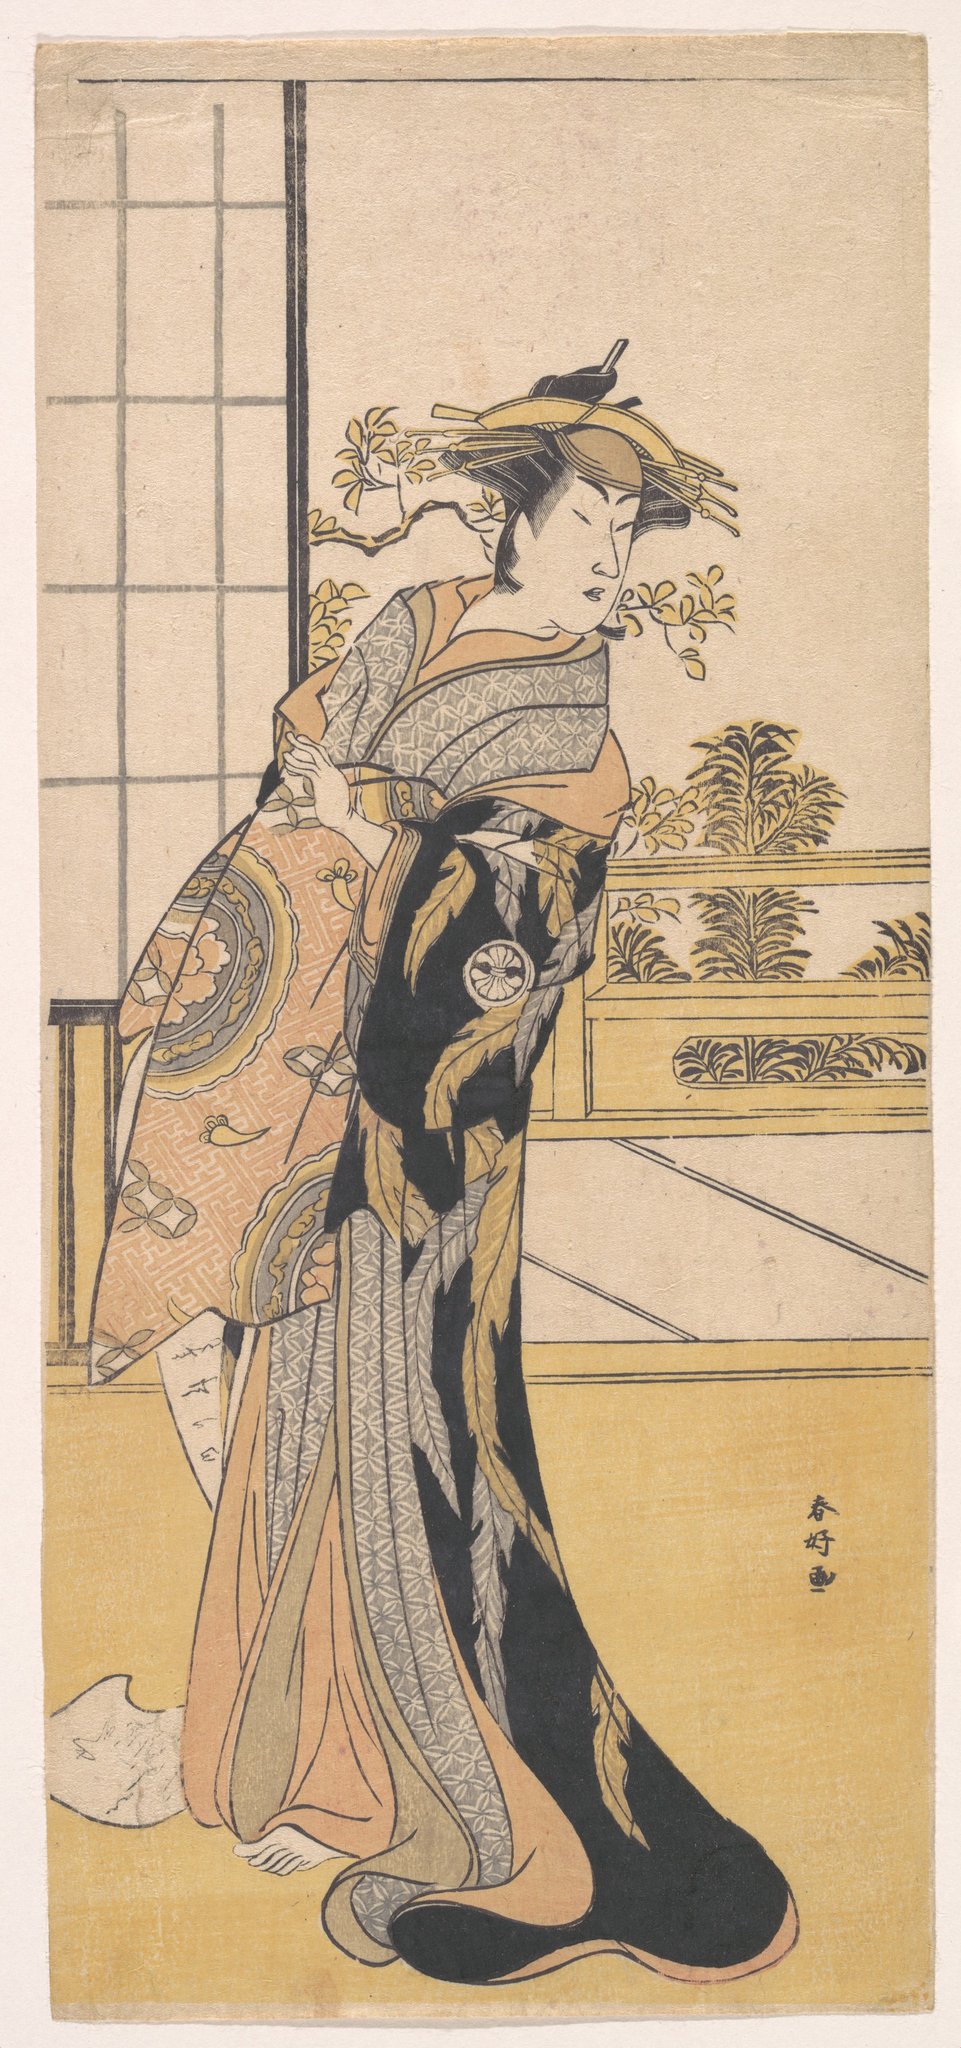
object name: print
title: The Actor Segawa Kikunojo 3rd in a Female Role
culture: japanese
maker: katsukawa shunkō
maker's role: artist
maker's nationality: japanese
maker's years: 1743-1812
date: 1780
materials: ink, paper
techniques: woodblock print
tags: women,actors